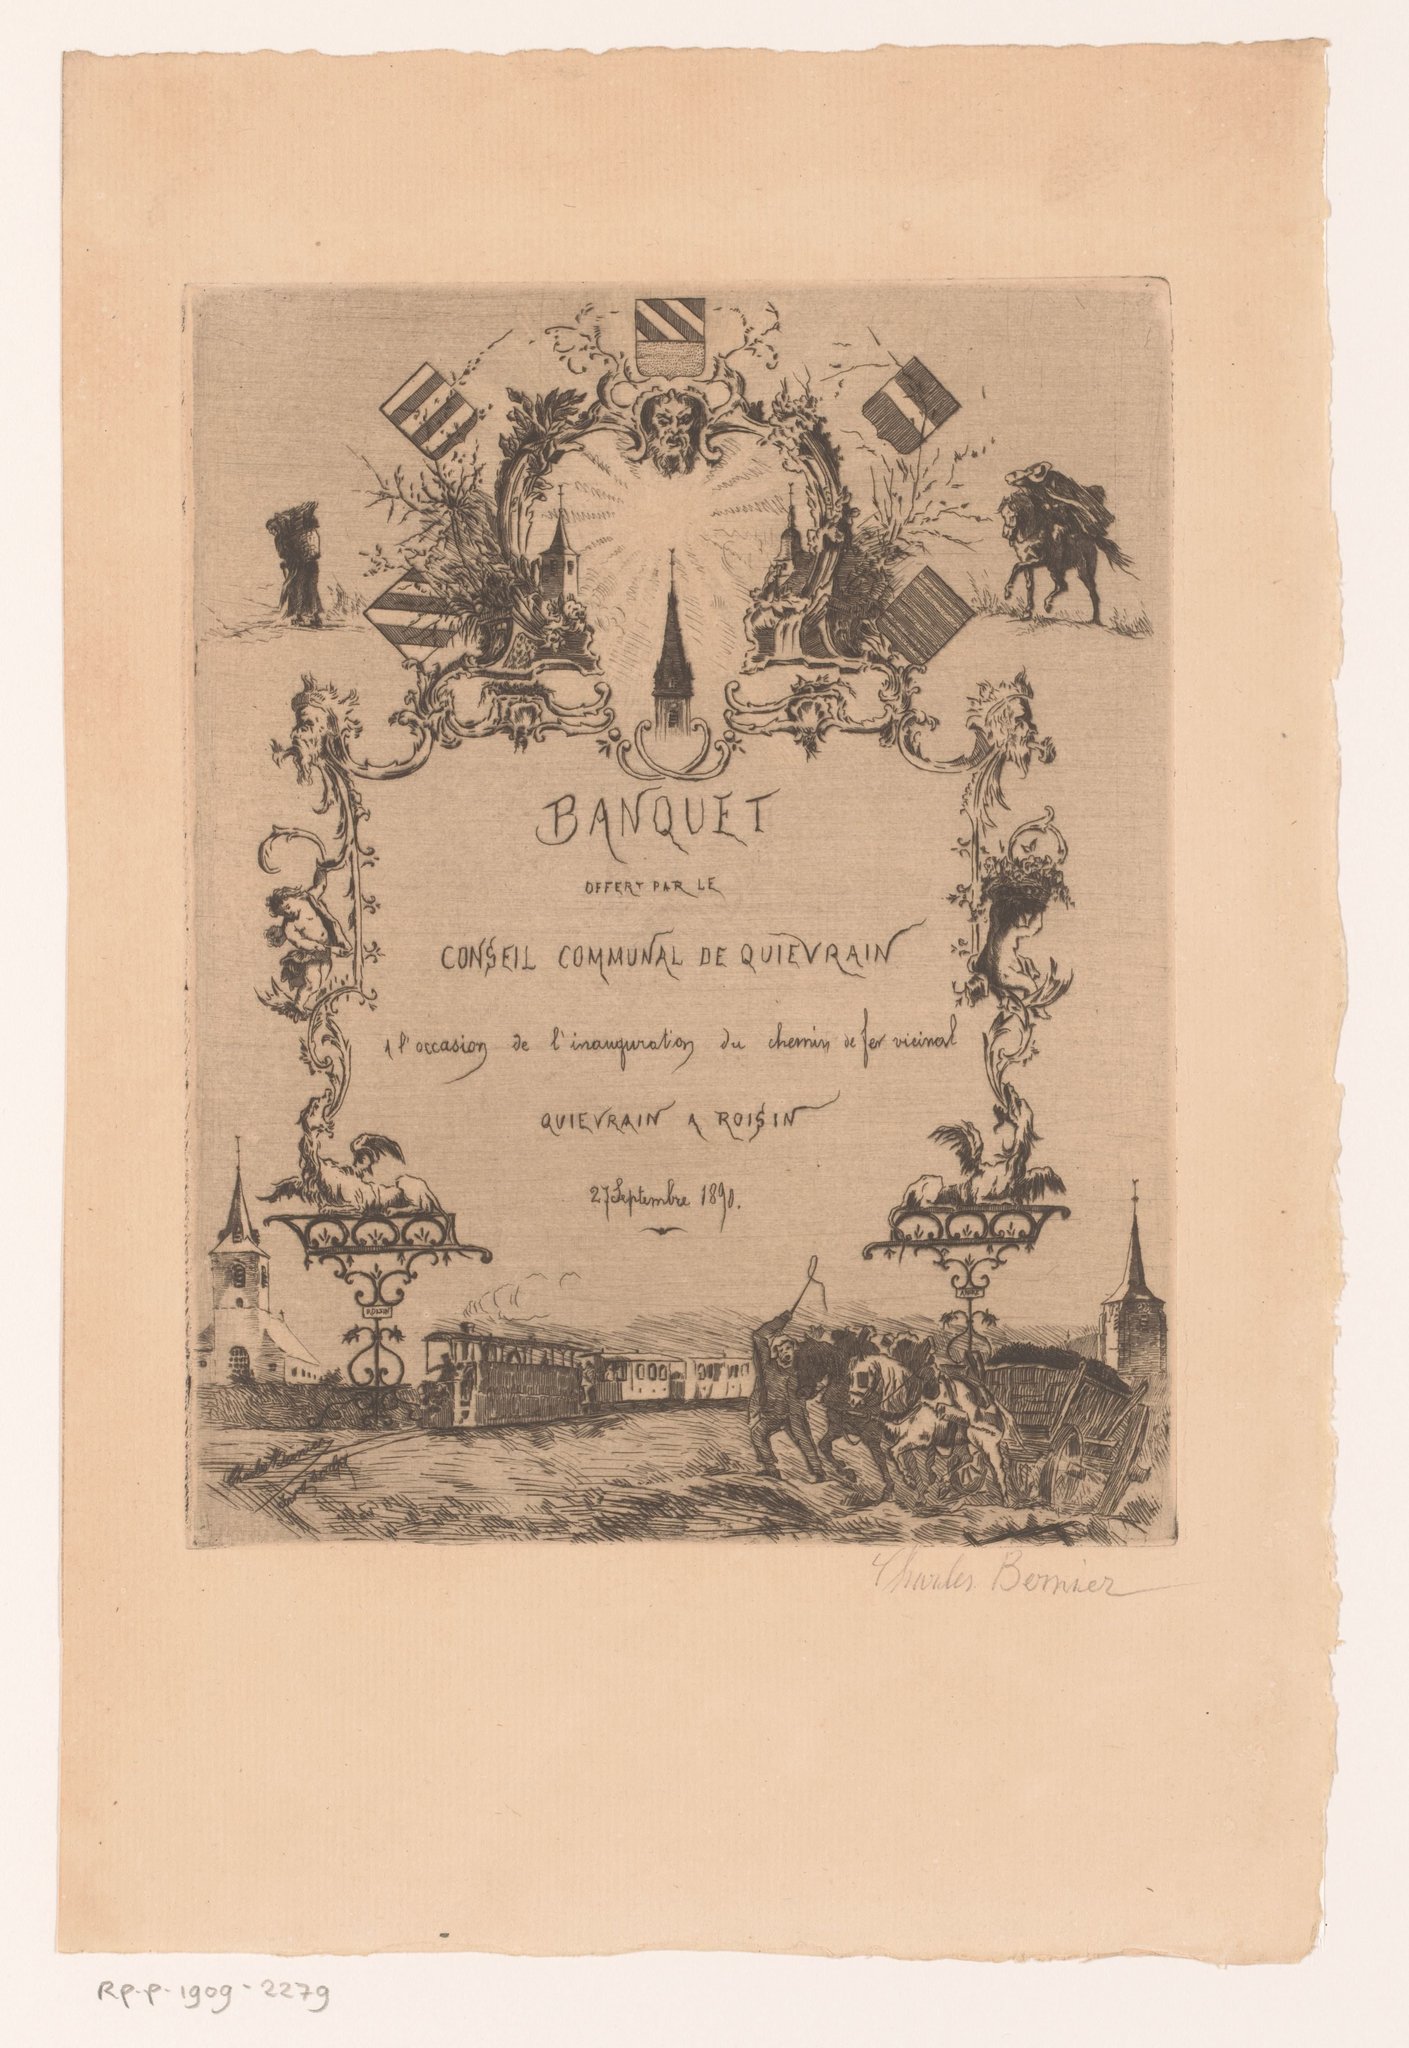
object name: print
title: Programma bij de inauguratie van de spoorweg tussen Quievrain en Roisin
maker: charles théodore bernier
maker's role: print maker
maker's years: 1871-1950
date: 1890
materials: paper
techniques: etching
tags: four-wheeled, animal-drawn vehicle, e.g.: cab, carriage, coach, railway, train, belgium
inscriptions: collector's mark: Lugt 2228